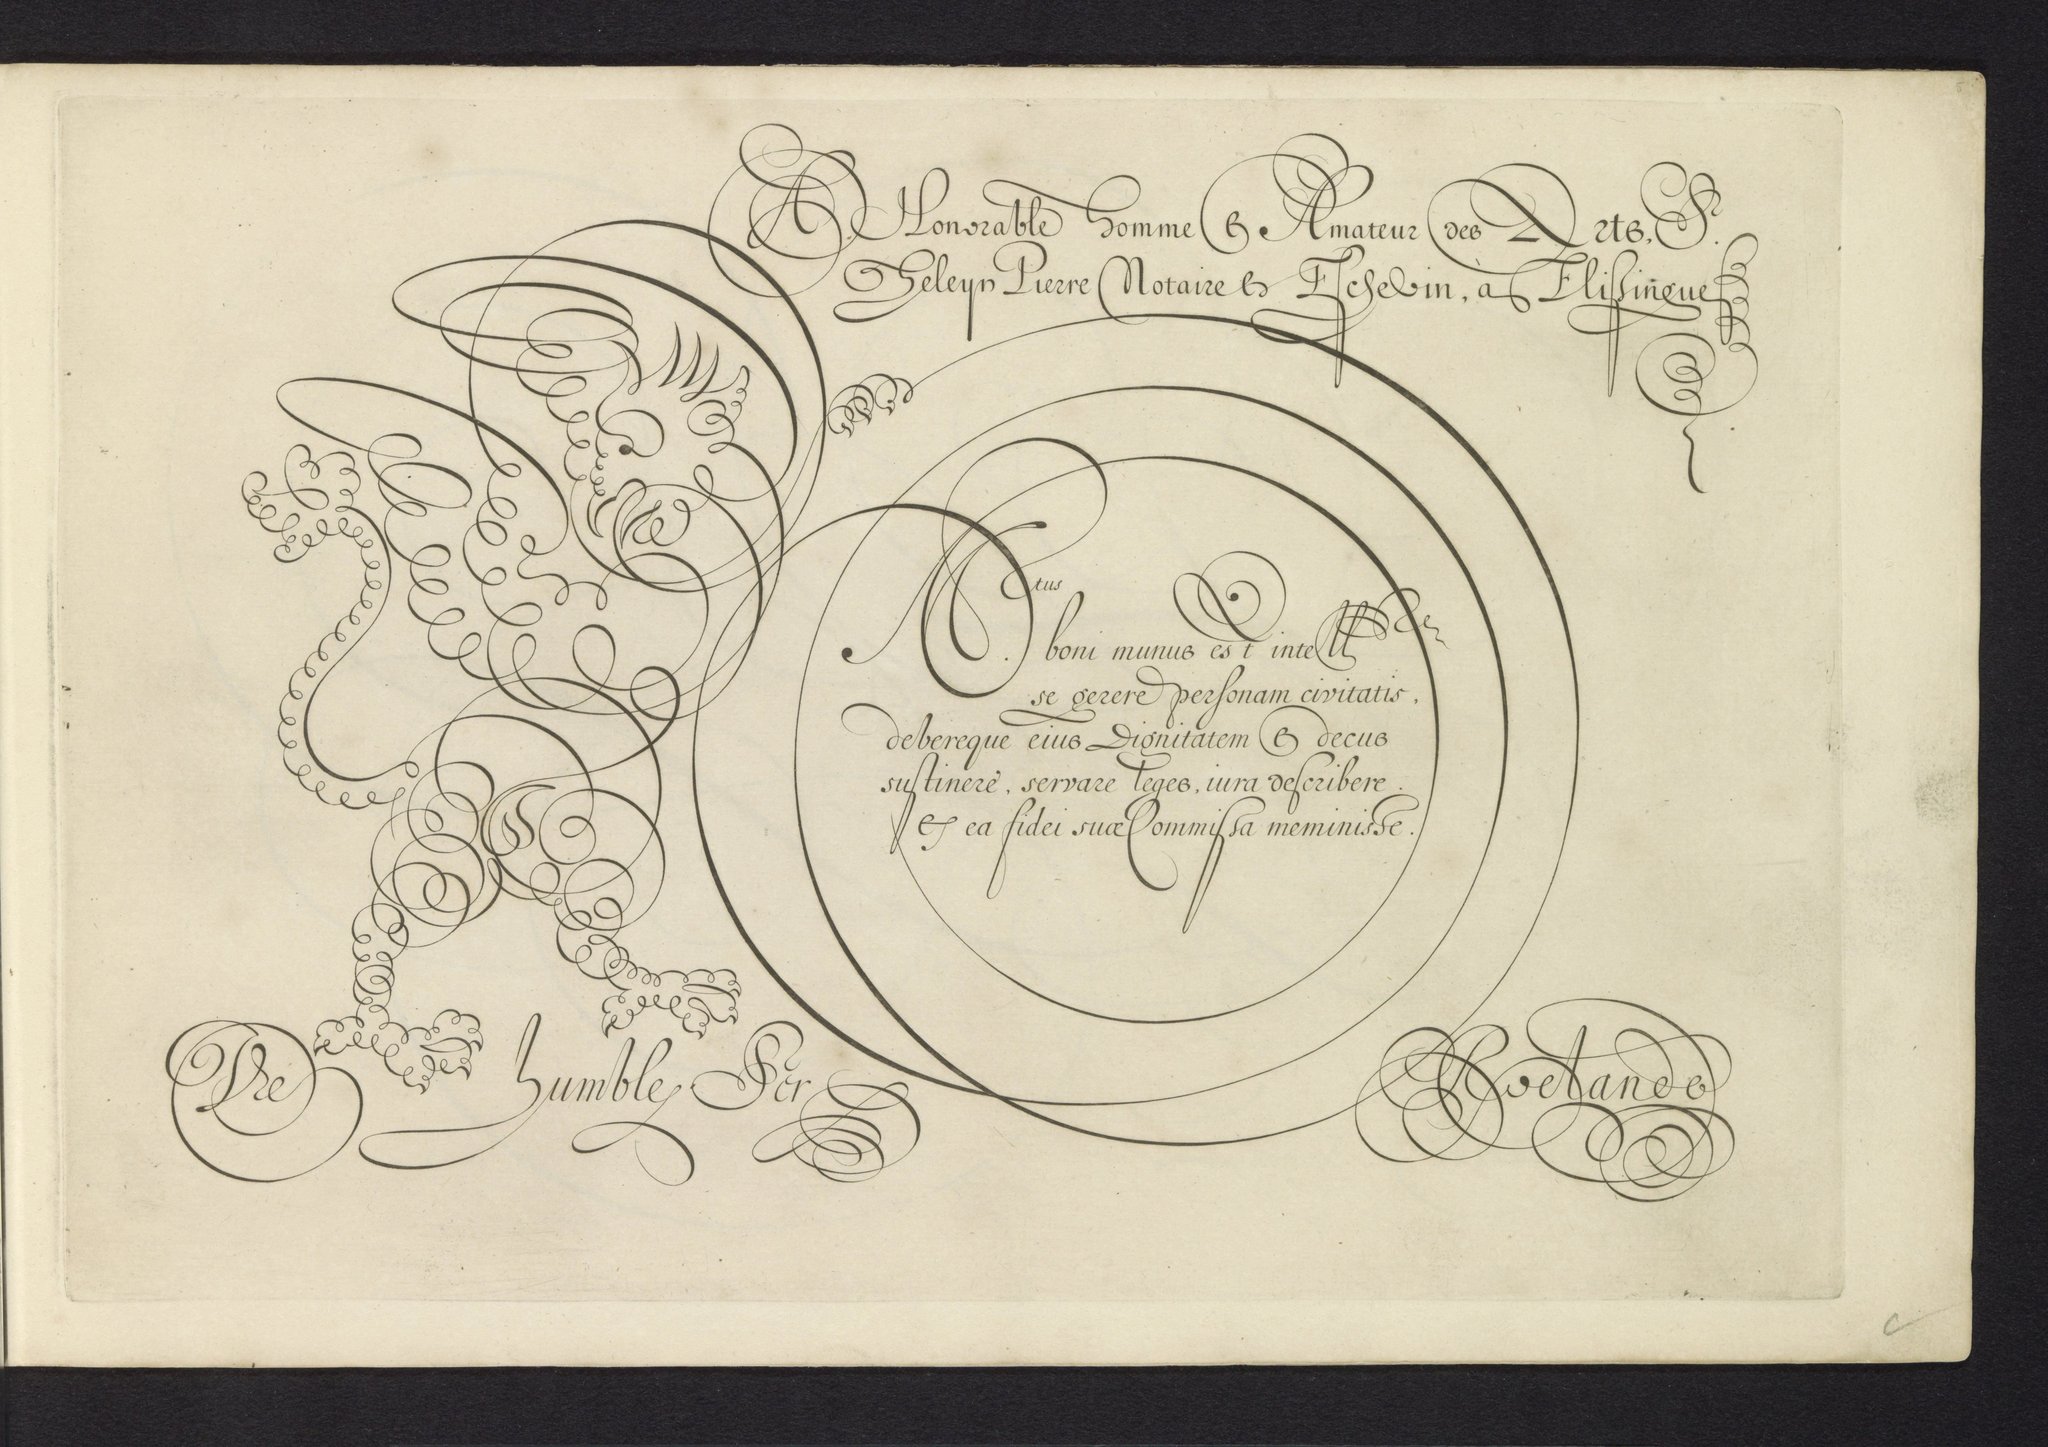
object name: album leaf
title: 't Magazin oft pac-huys der loffelycker penn-const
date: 1616-1617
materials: paper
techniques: engraving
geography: flushing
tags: calligraphy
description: Schrijfvoorbeeld met vijf regels tekst in het Latijn: M(tus) boni munus est ... Daarboven in het Frans een opdracht aan Geleyn Pieters, schepen te Vlissingen. Links een griffioen in krulwerk. De prent maakt deel uit van een album getiteld: Prijs boek van Jan Malnoe.